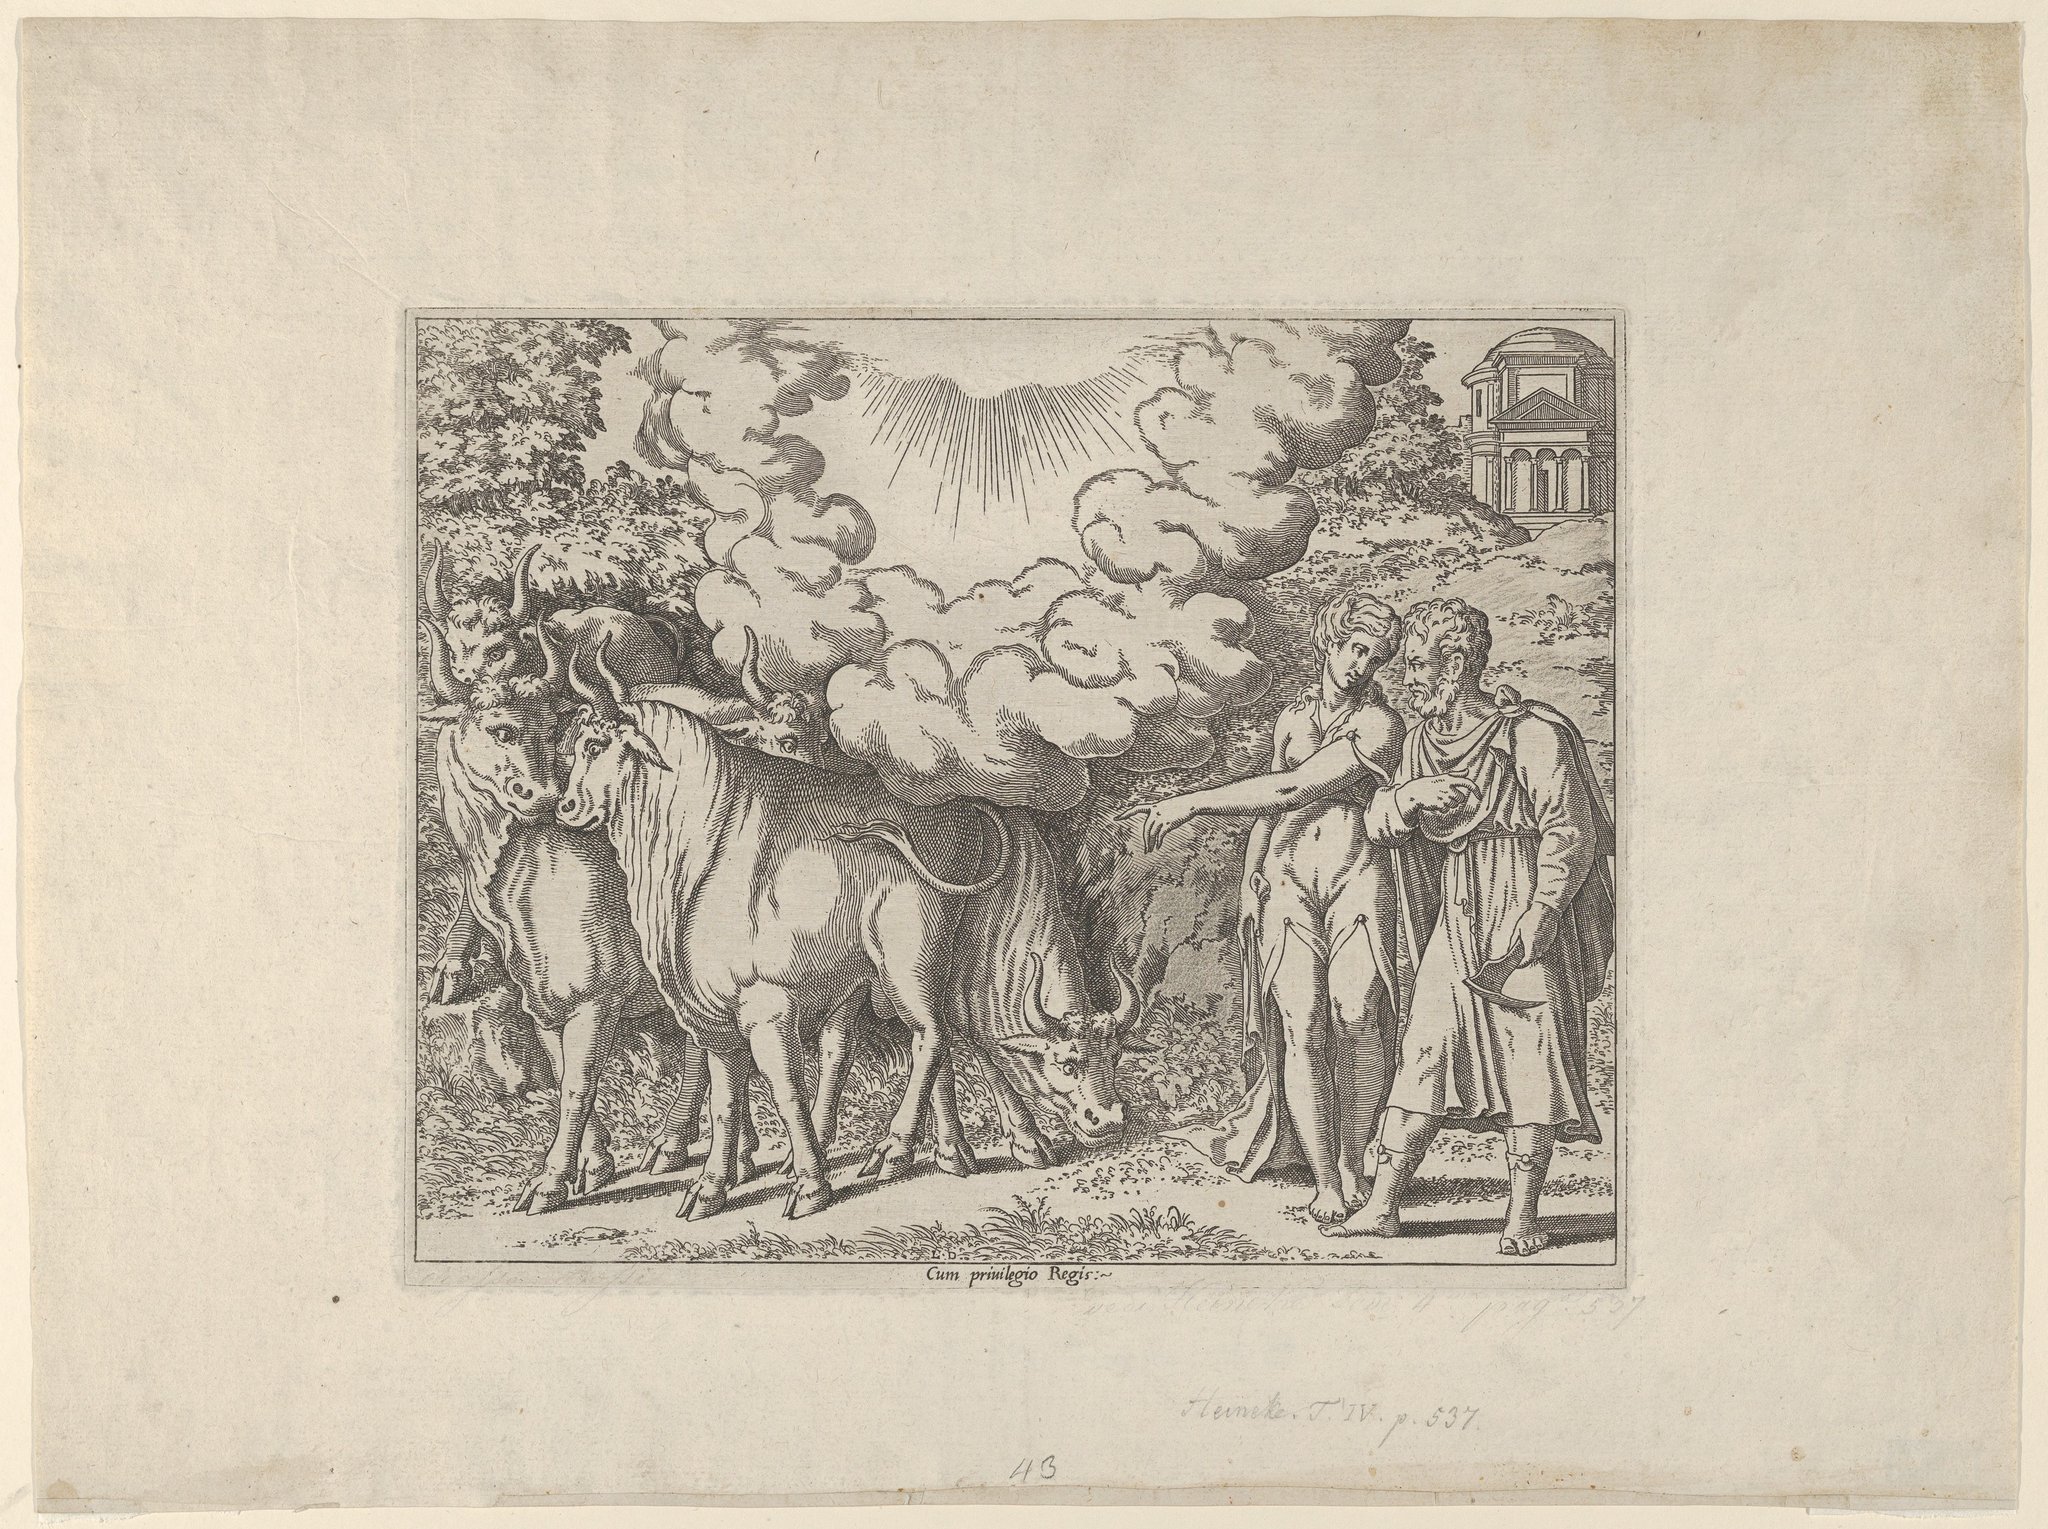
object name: print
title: A Woman Showing Bulls to a Man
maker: léon davent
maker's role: artist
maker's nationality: french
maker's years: 1540-1556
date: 1540-1545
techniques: etching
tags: men,female nudes,bulls